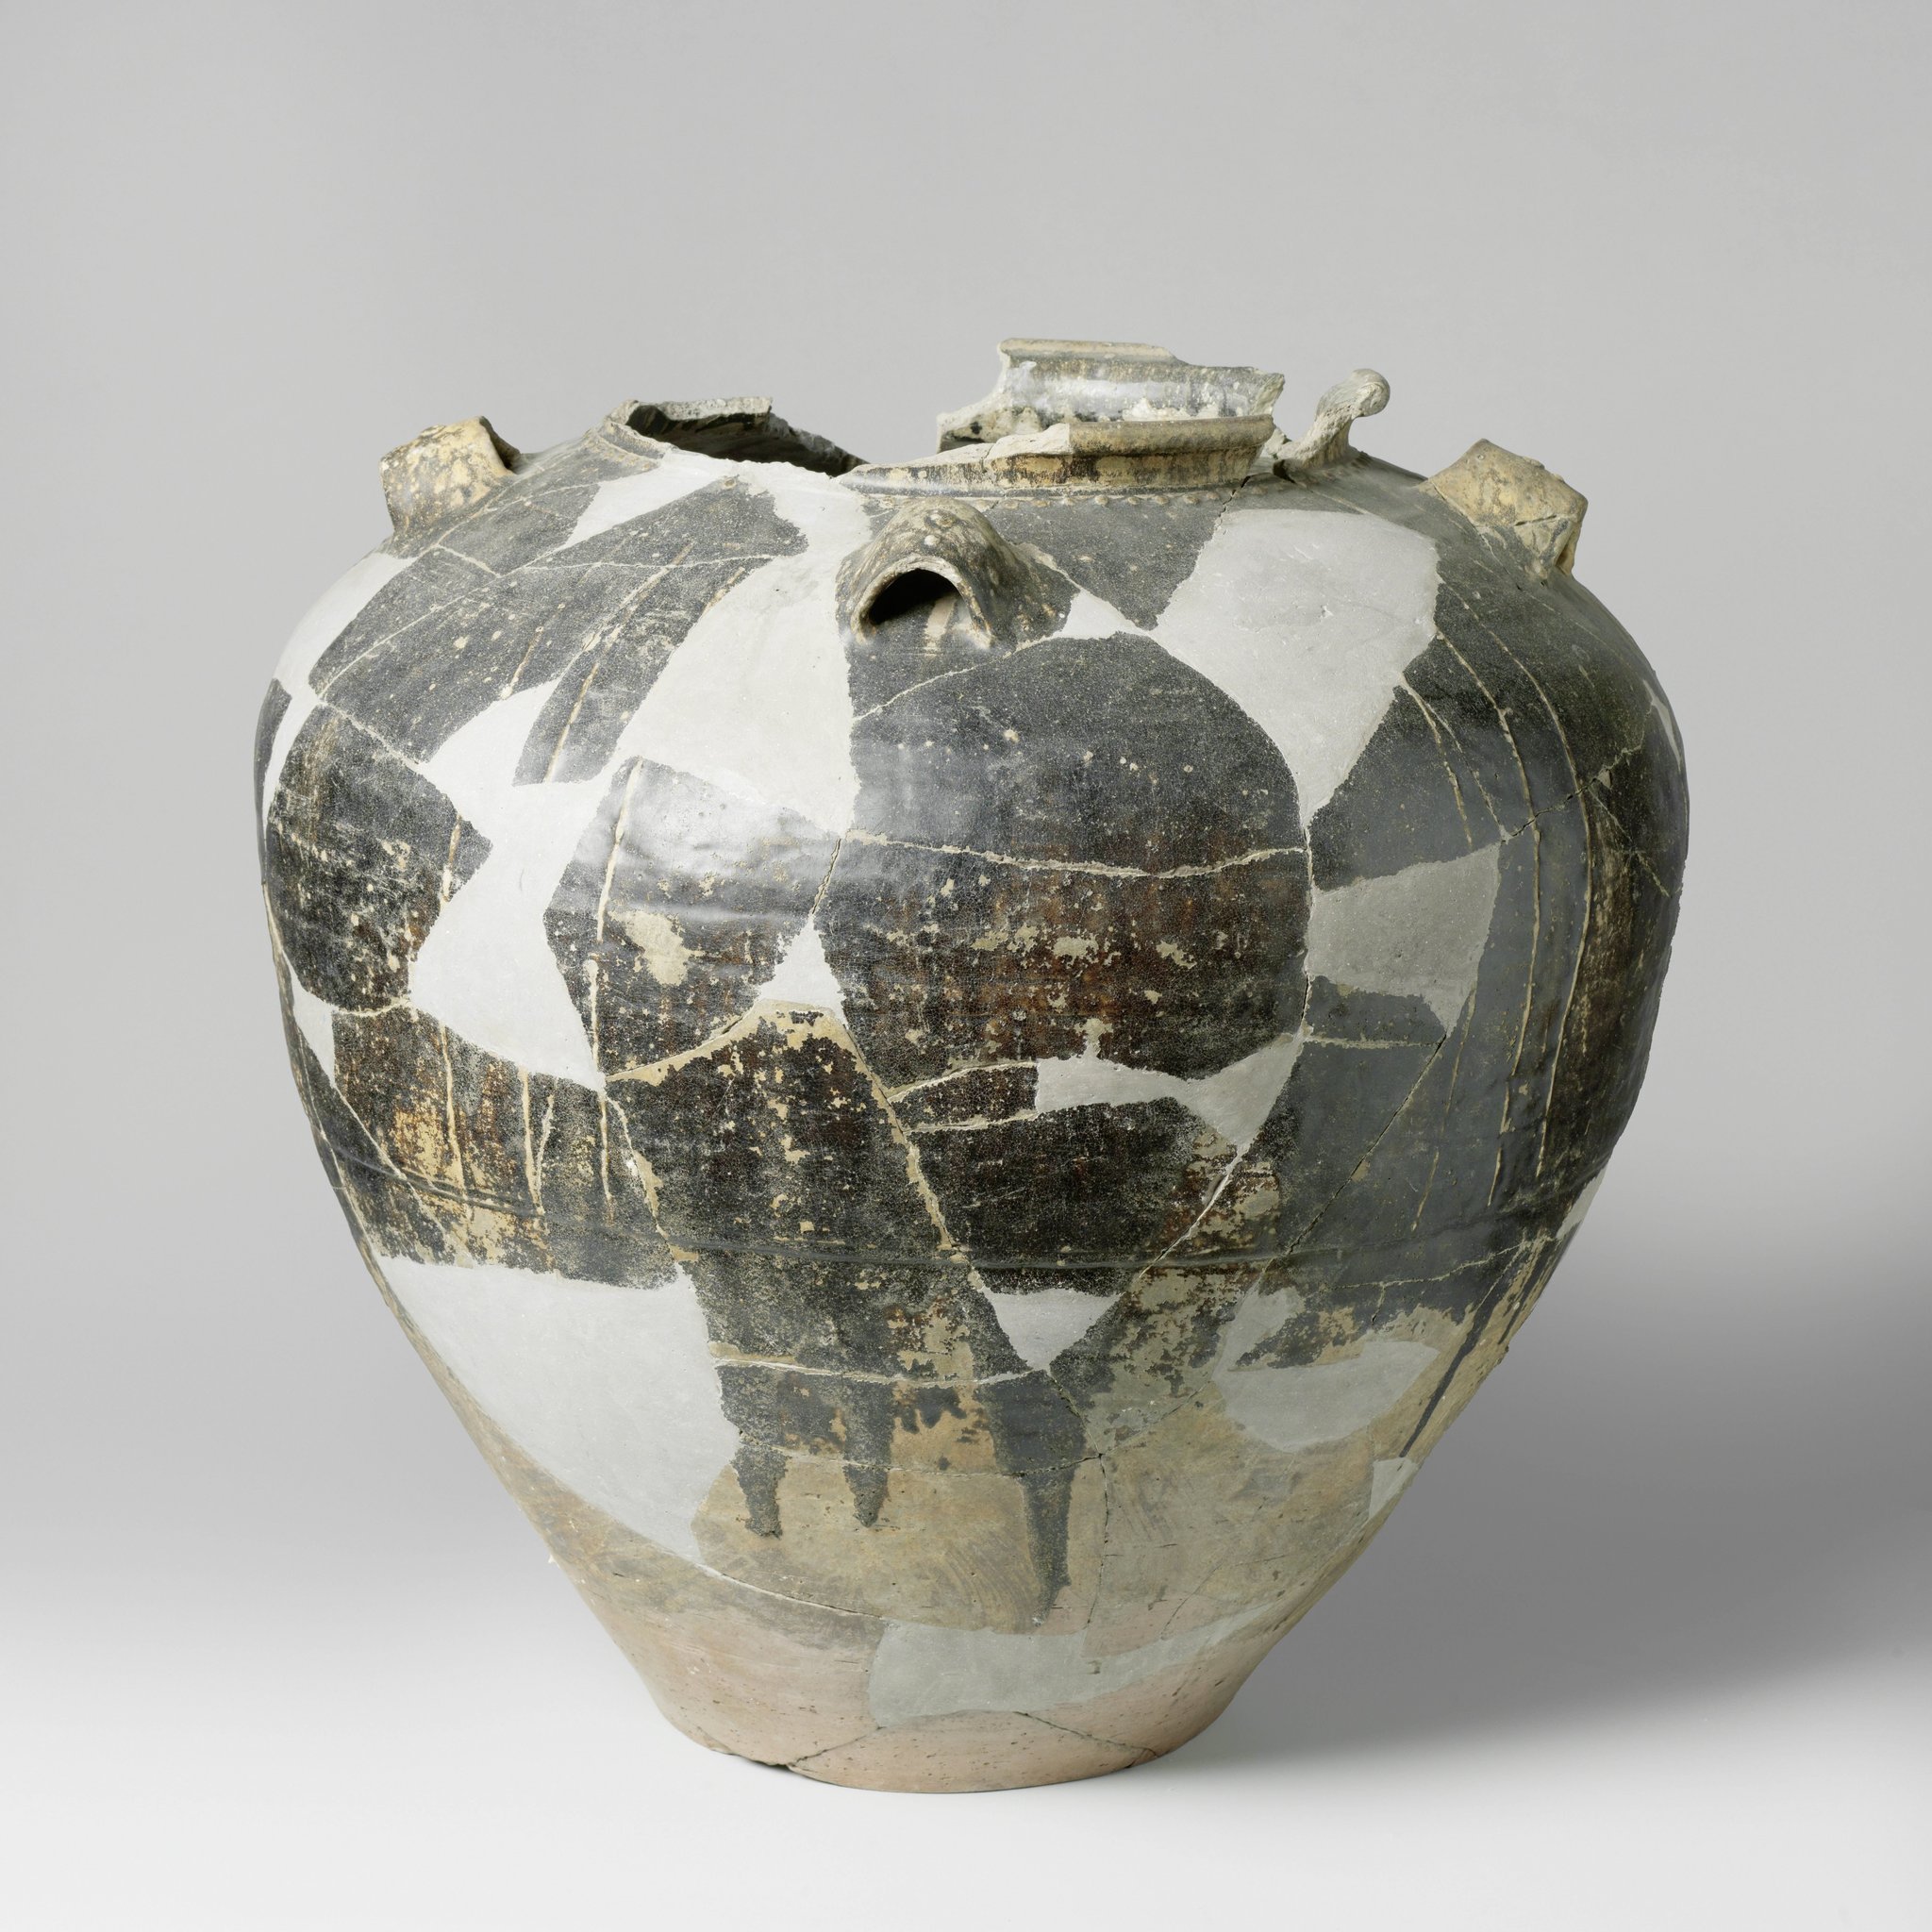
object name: martavaan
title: Martavaan uit V.O.C.-schip de 'Witte Leeuw'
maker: Anonymous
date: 1613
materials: porcelain, stoneware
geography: martaban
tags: verenigde oostindische compagnie, sint-helena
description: A jar. On the interior, only the lip is glazed. Beneath neck and shoulder is a band with underneath a dotted line. Bands of slip run down from the height of the ears till one-third of the lower part. The ears are decorated with dots made of the same type of clay as the body. The jar has been made in two parts: the upper half is larger than the lower half. A similar jar was found in the wreck of the San Antonio da Tanna sunk in 1697.